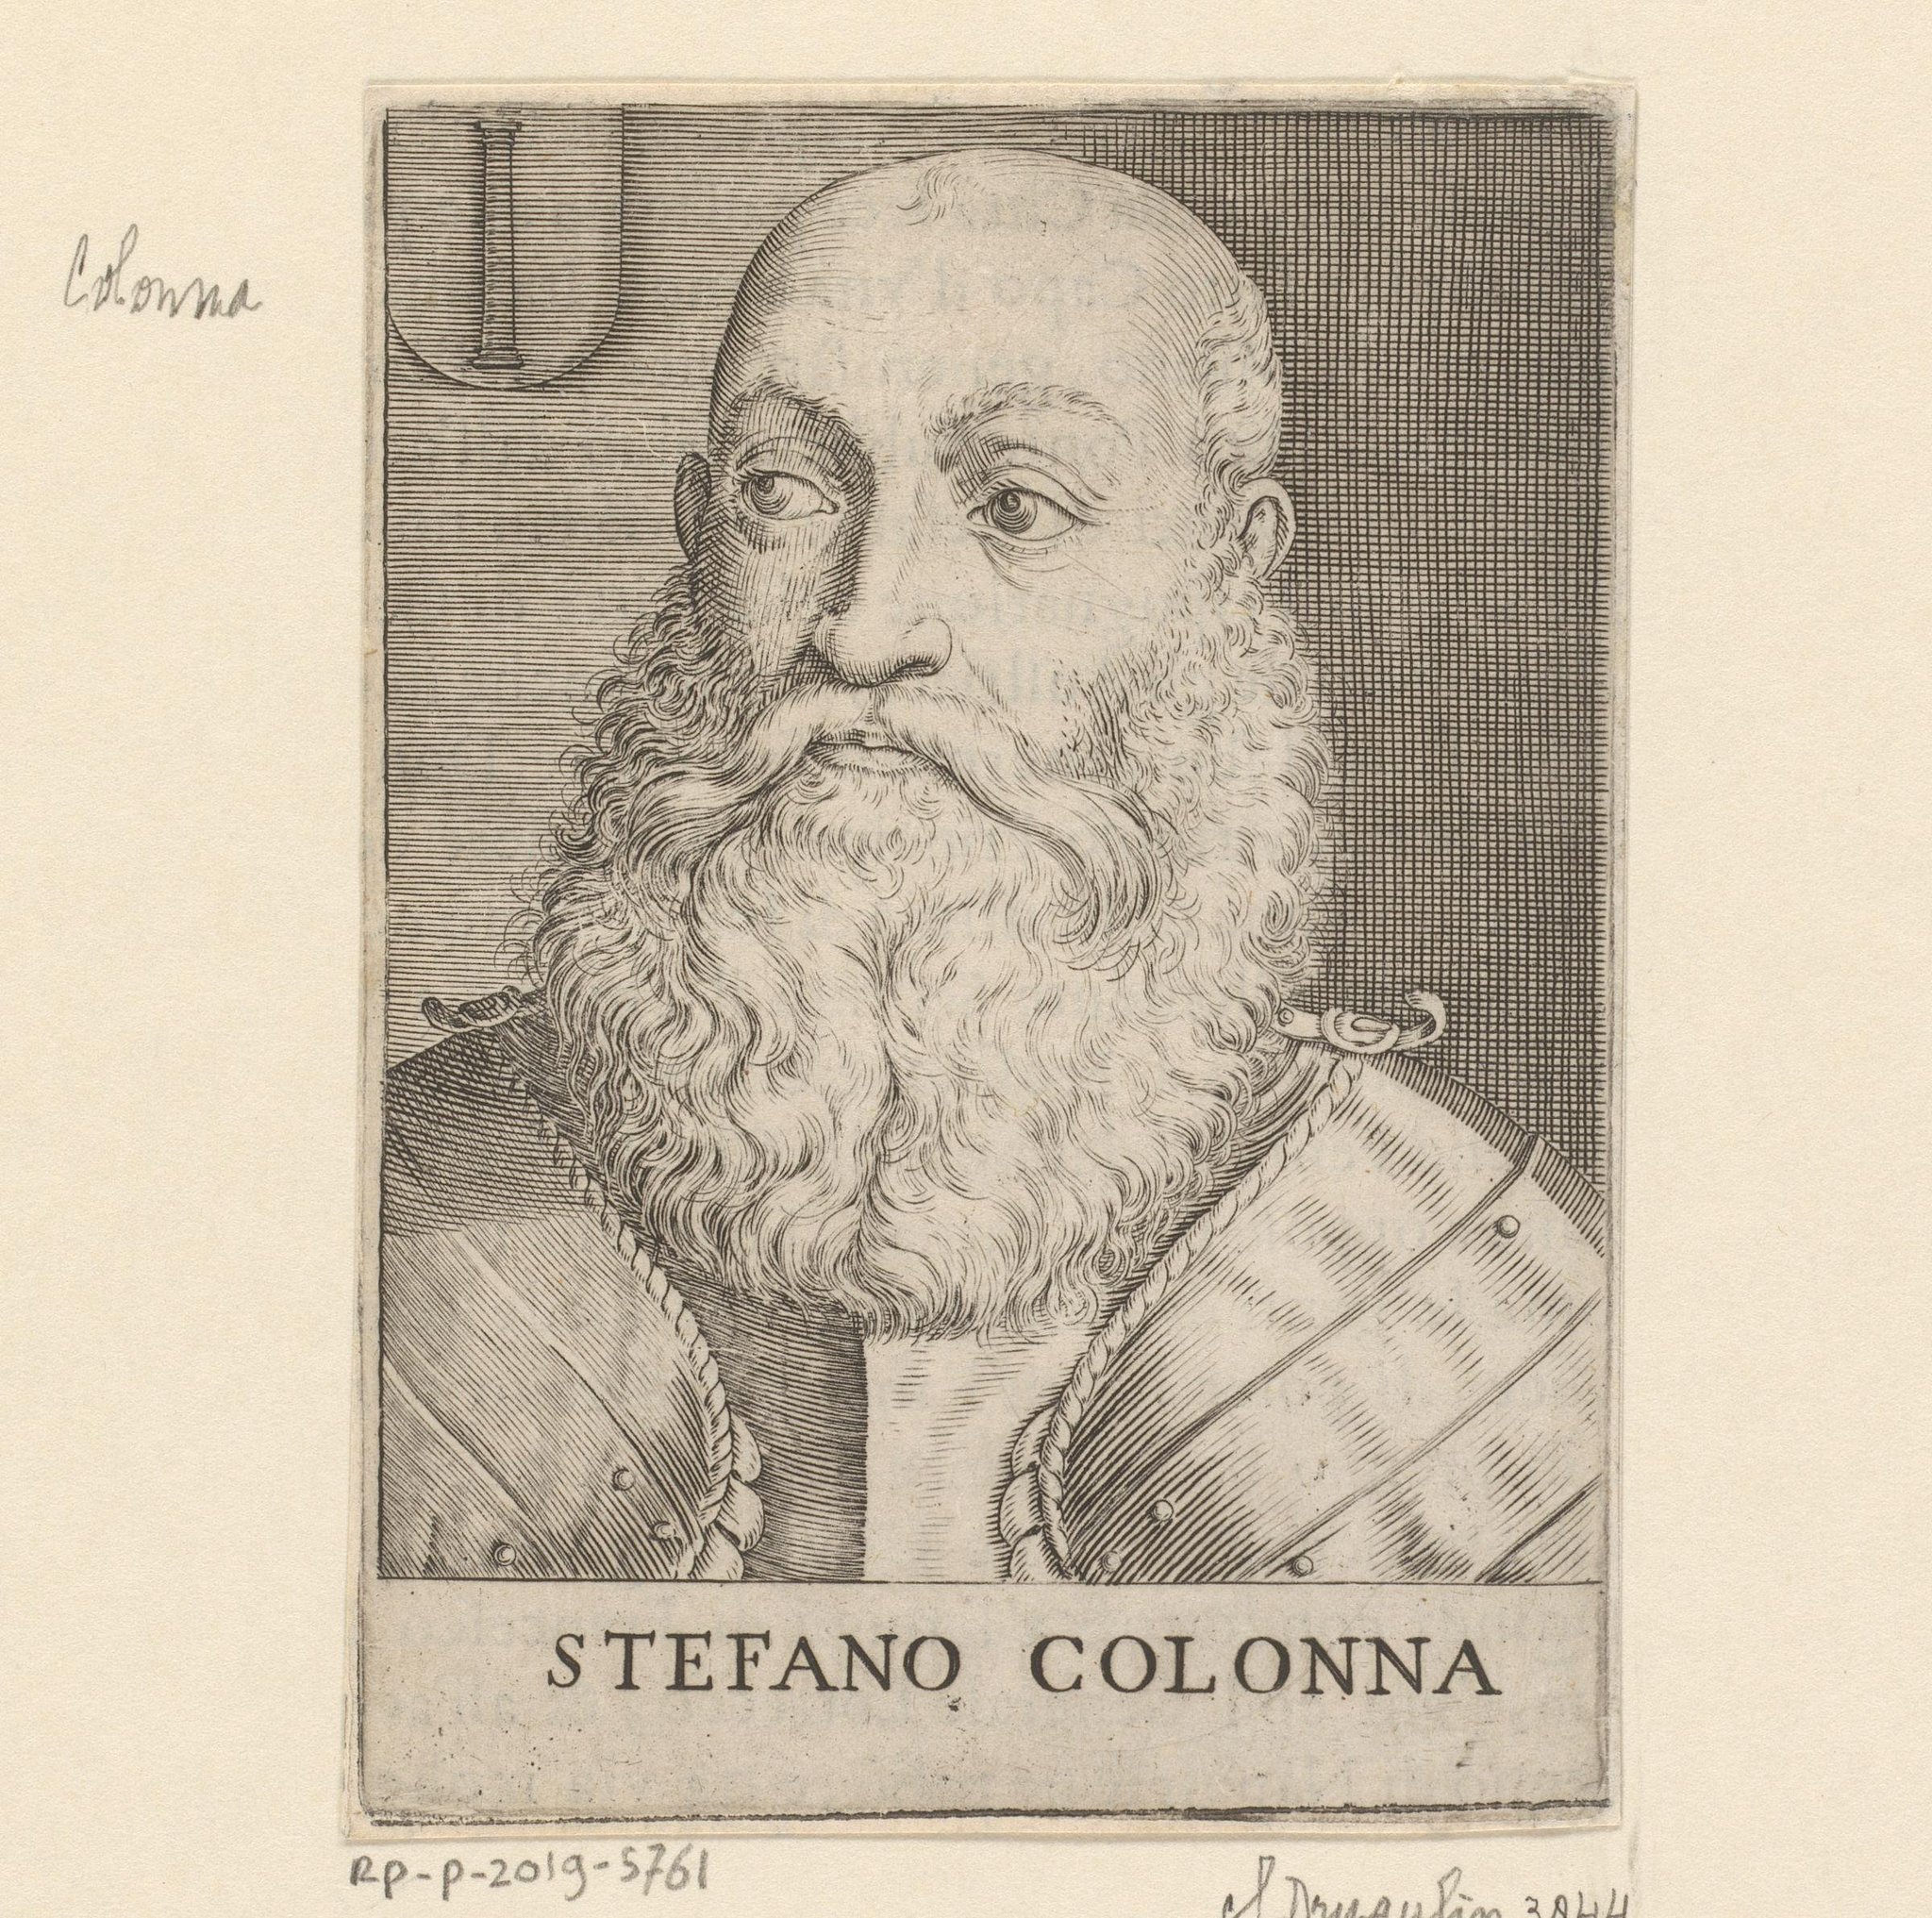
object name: book illustration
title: Portret van legeraanvoerder Stefano Colonna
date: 1646-1647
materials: paper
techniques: engraving, letterpress printing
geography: rome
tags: commander-in-chief, general, marshal, historical persons, armorial bearing, heraldry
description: Prent uit: Ritratti et elogii di capitani Illustri. Che ne'secoli moderni hanno gloriosamente guerreggiato. Rome: Filippo de'Rossi en Vitale Mascardi, 1646, p. 297. Prent ook gebruikt in dezelfde editie van 1647. Eerdere staten van prent in ieder geval gebruikt in: Ritratti et elogii di capitani Illustri. Rome: Pompilio Totti en Andrea Fei, 1635. En in: Ritratti di cento capitani illustri con li lor Fatti in guerra (…), Rome: Domenico Gigliotti, 1596.